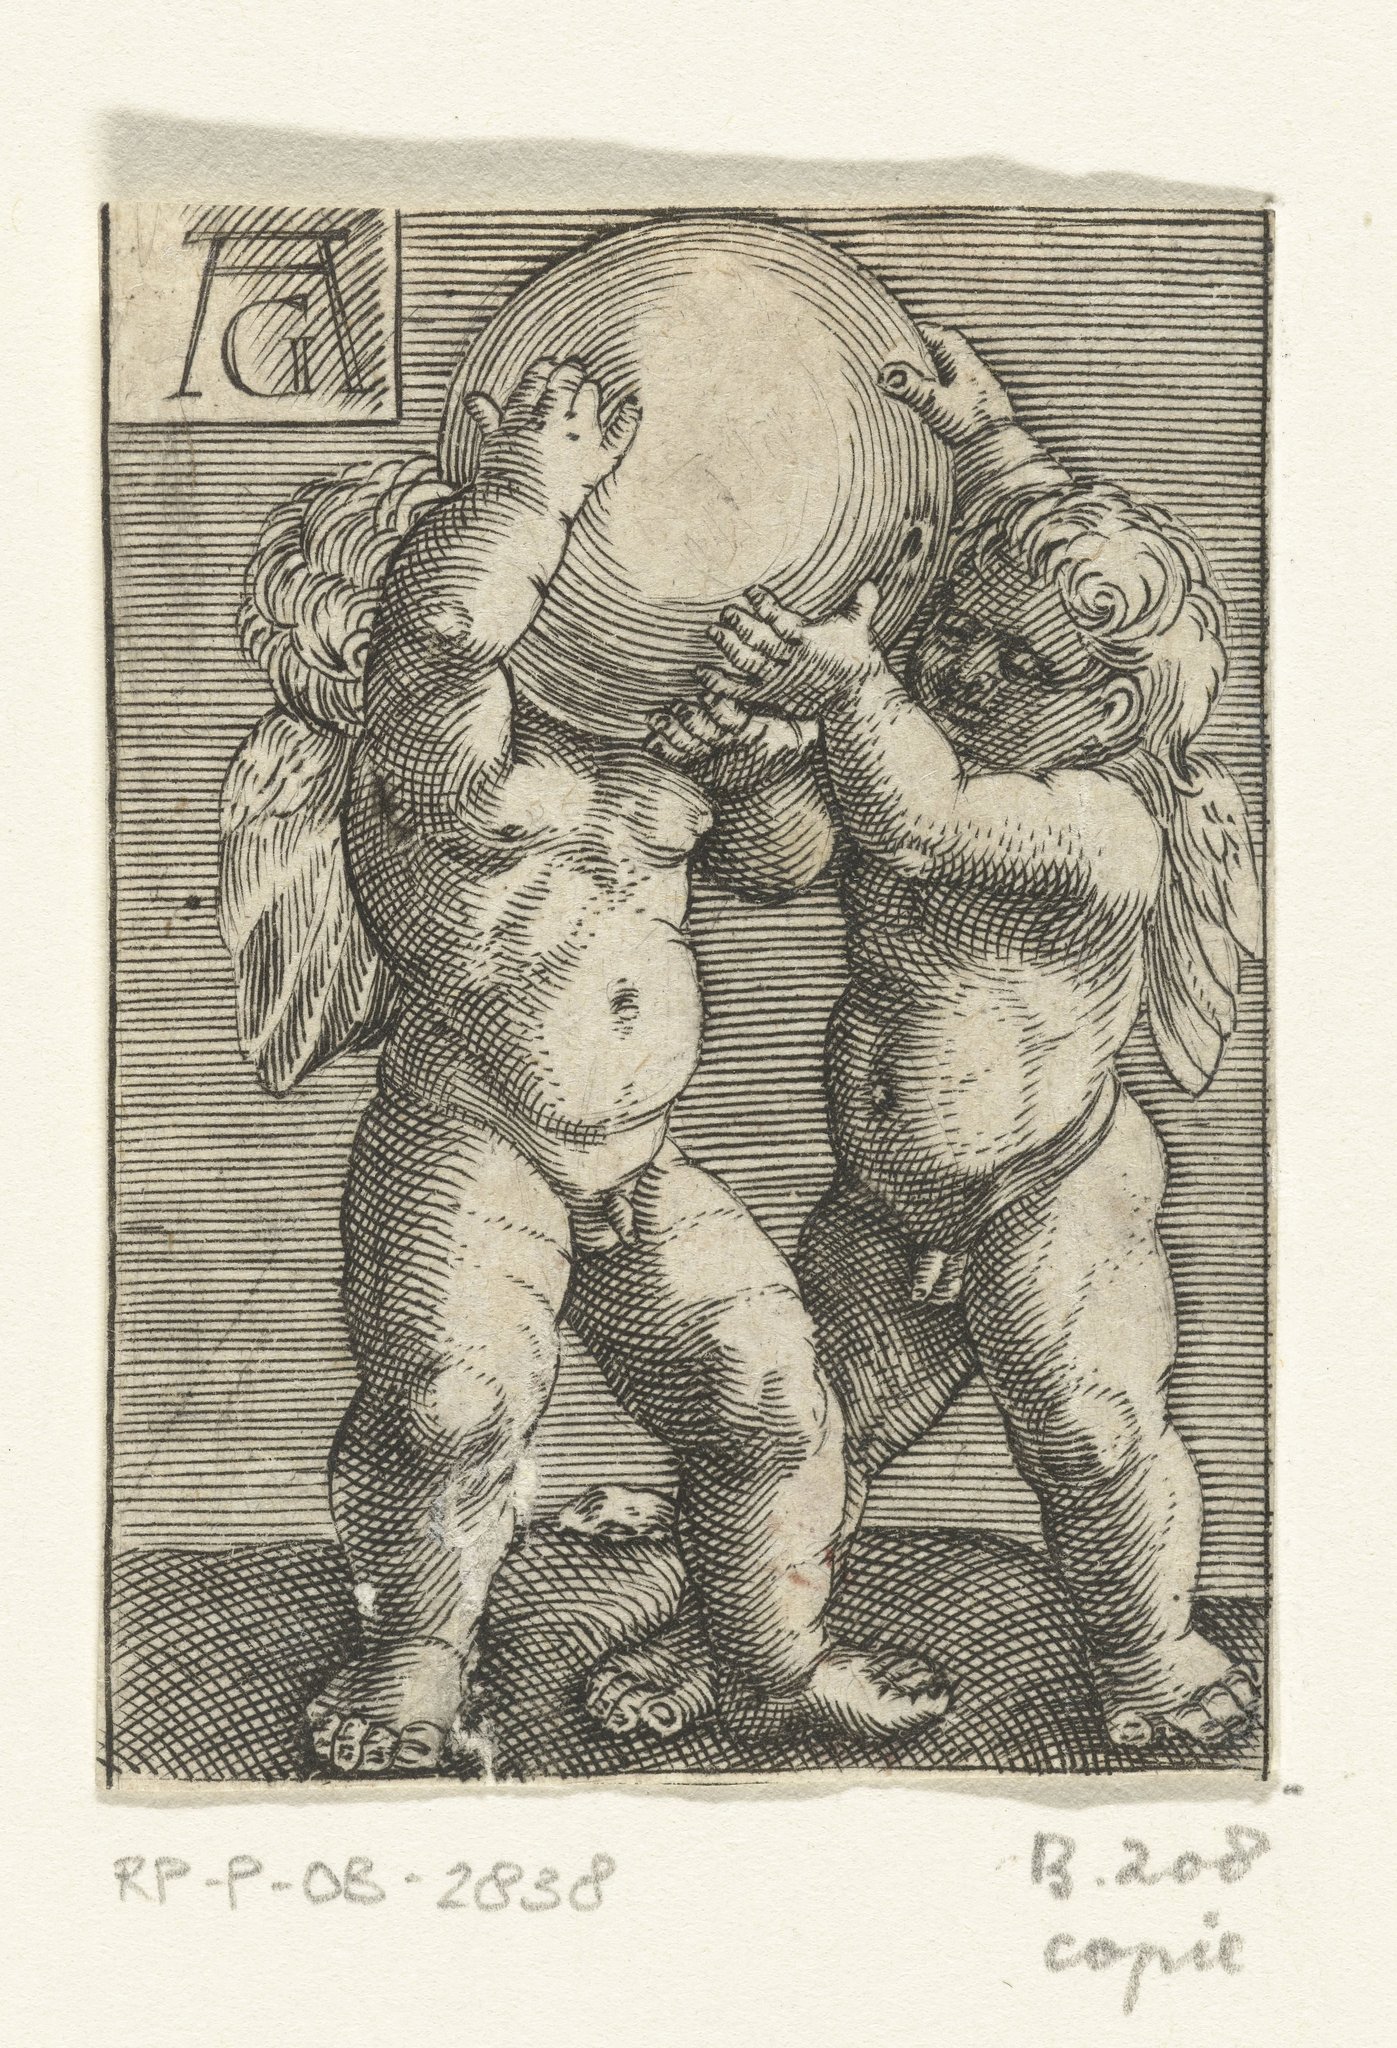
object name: ornament print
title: Twee putti die een bol dragen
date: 1512-1610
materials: paper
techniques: engraving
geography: germany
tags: ornaments ~ art, cupids: 'amores', 'amoretti', 'putti'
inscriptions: collector's mark: Lugt 240, number: ‘11’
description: Spiegelbeeldige kopie naar een prent van Aldegrever. Botke, K.